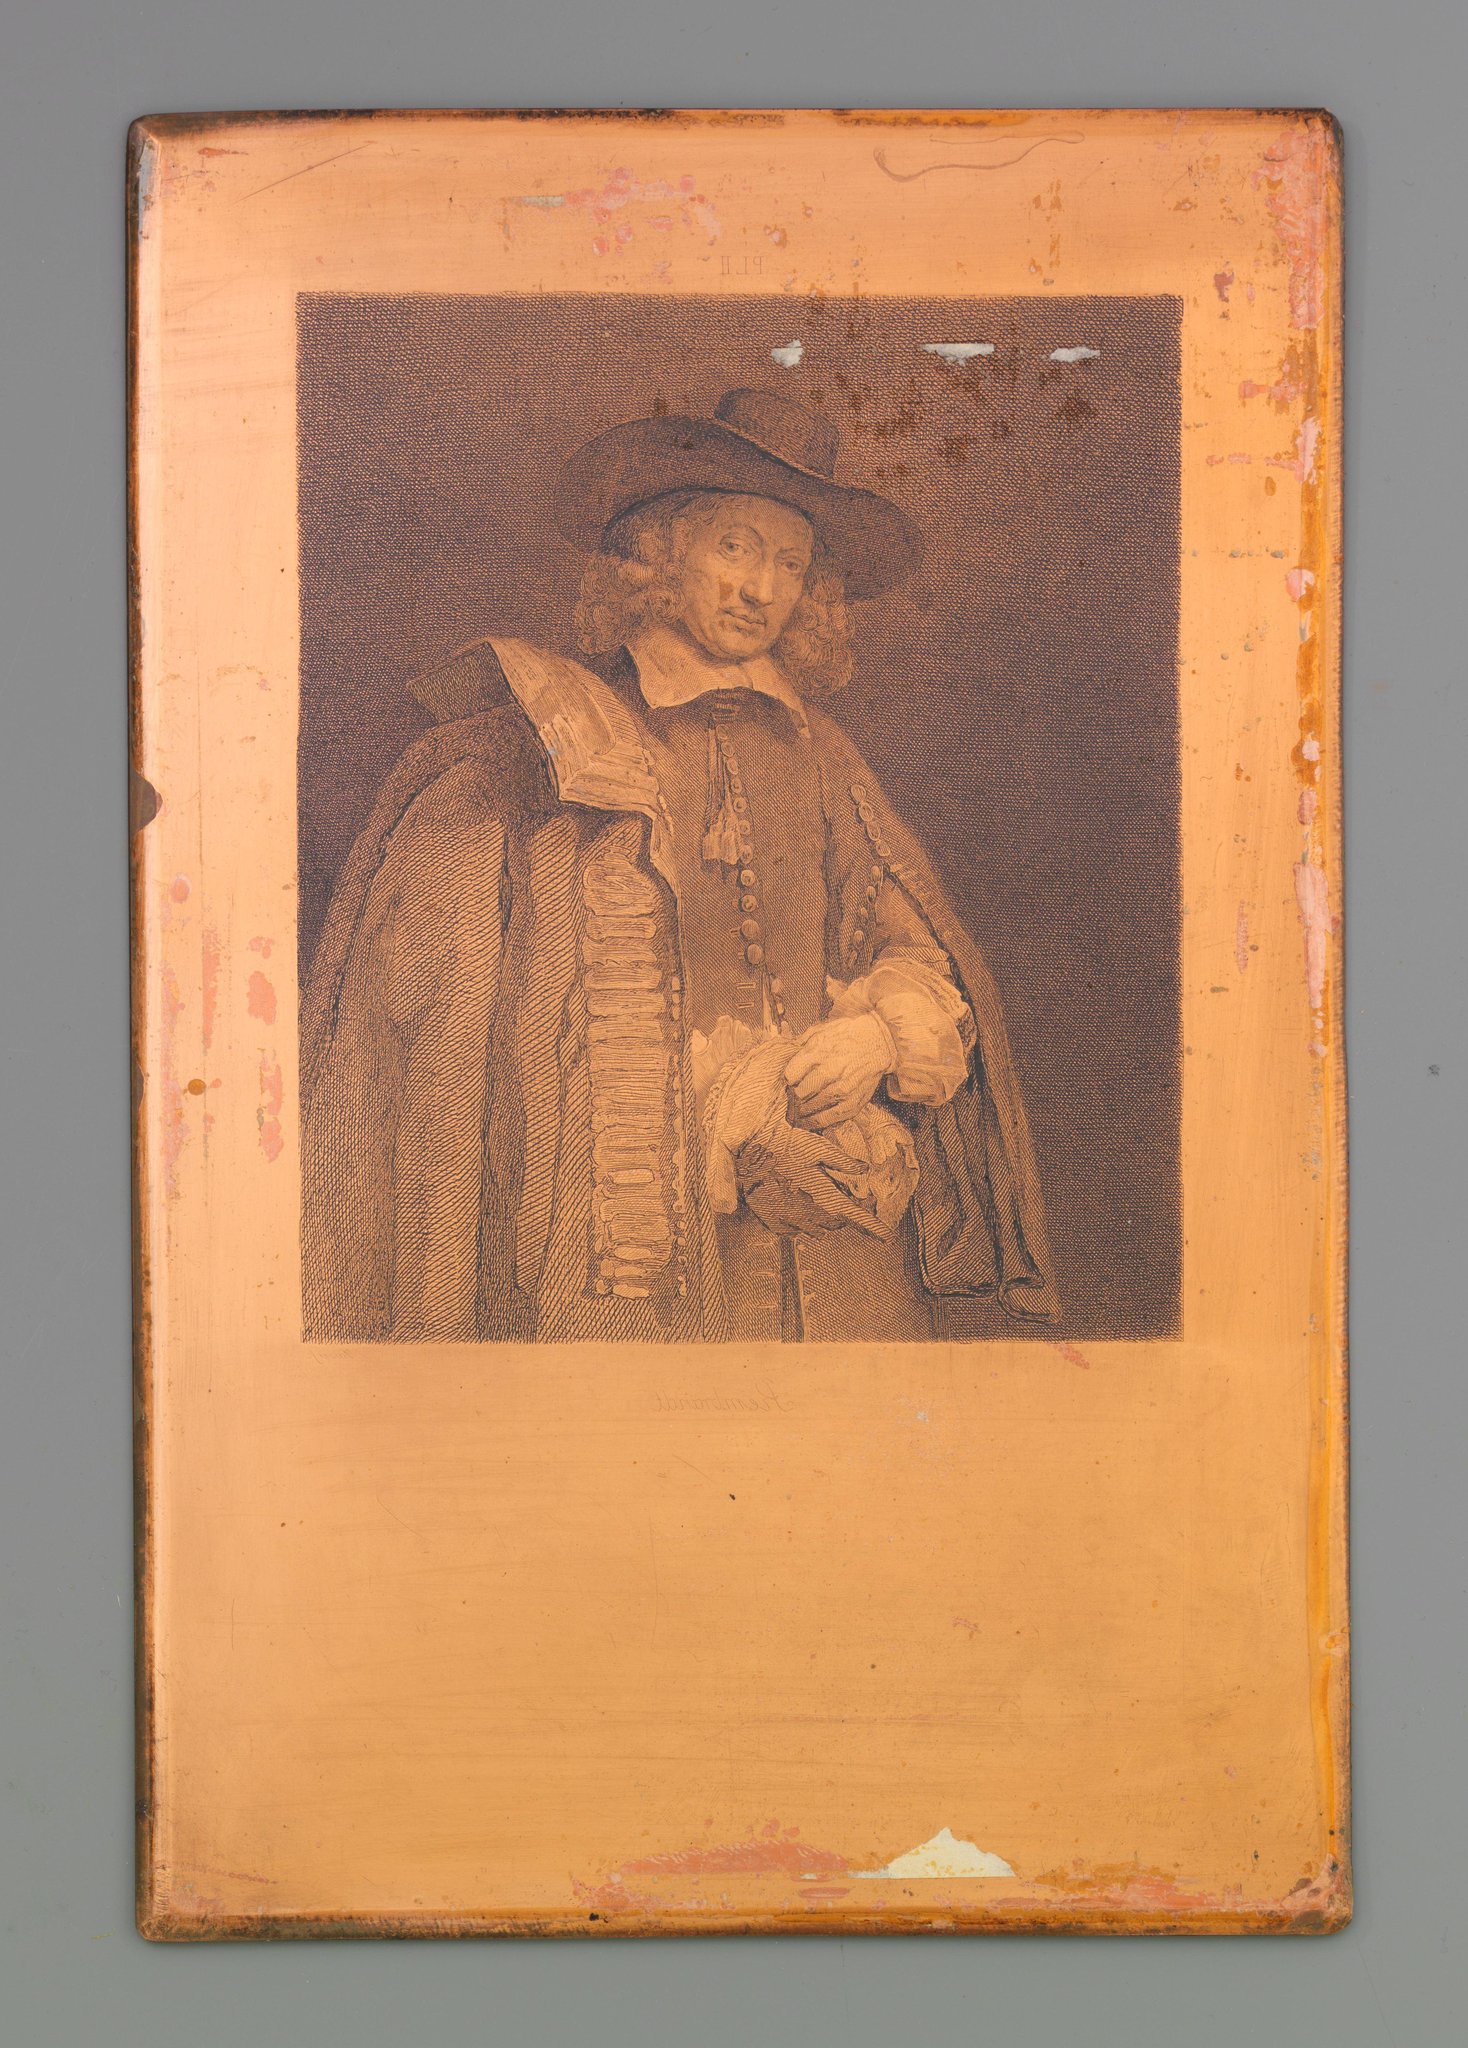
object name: copper plate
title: Portret van Jan Six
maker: johann wilhelm kaiser (i)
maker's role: draughtsman, print maker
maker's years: 1813-1900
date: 1823-1900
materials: copper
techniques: etching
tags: mayor, jan six (1618-1700)